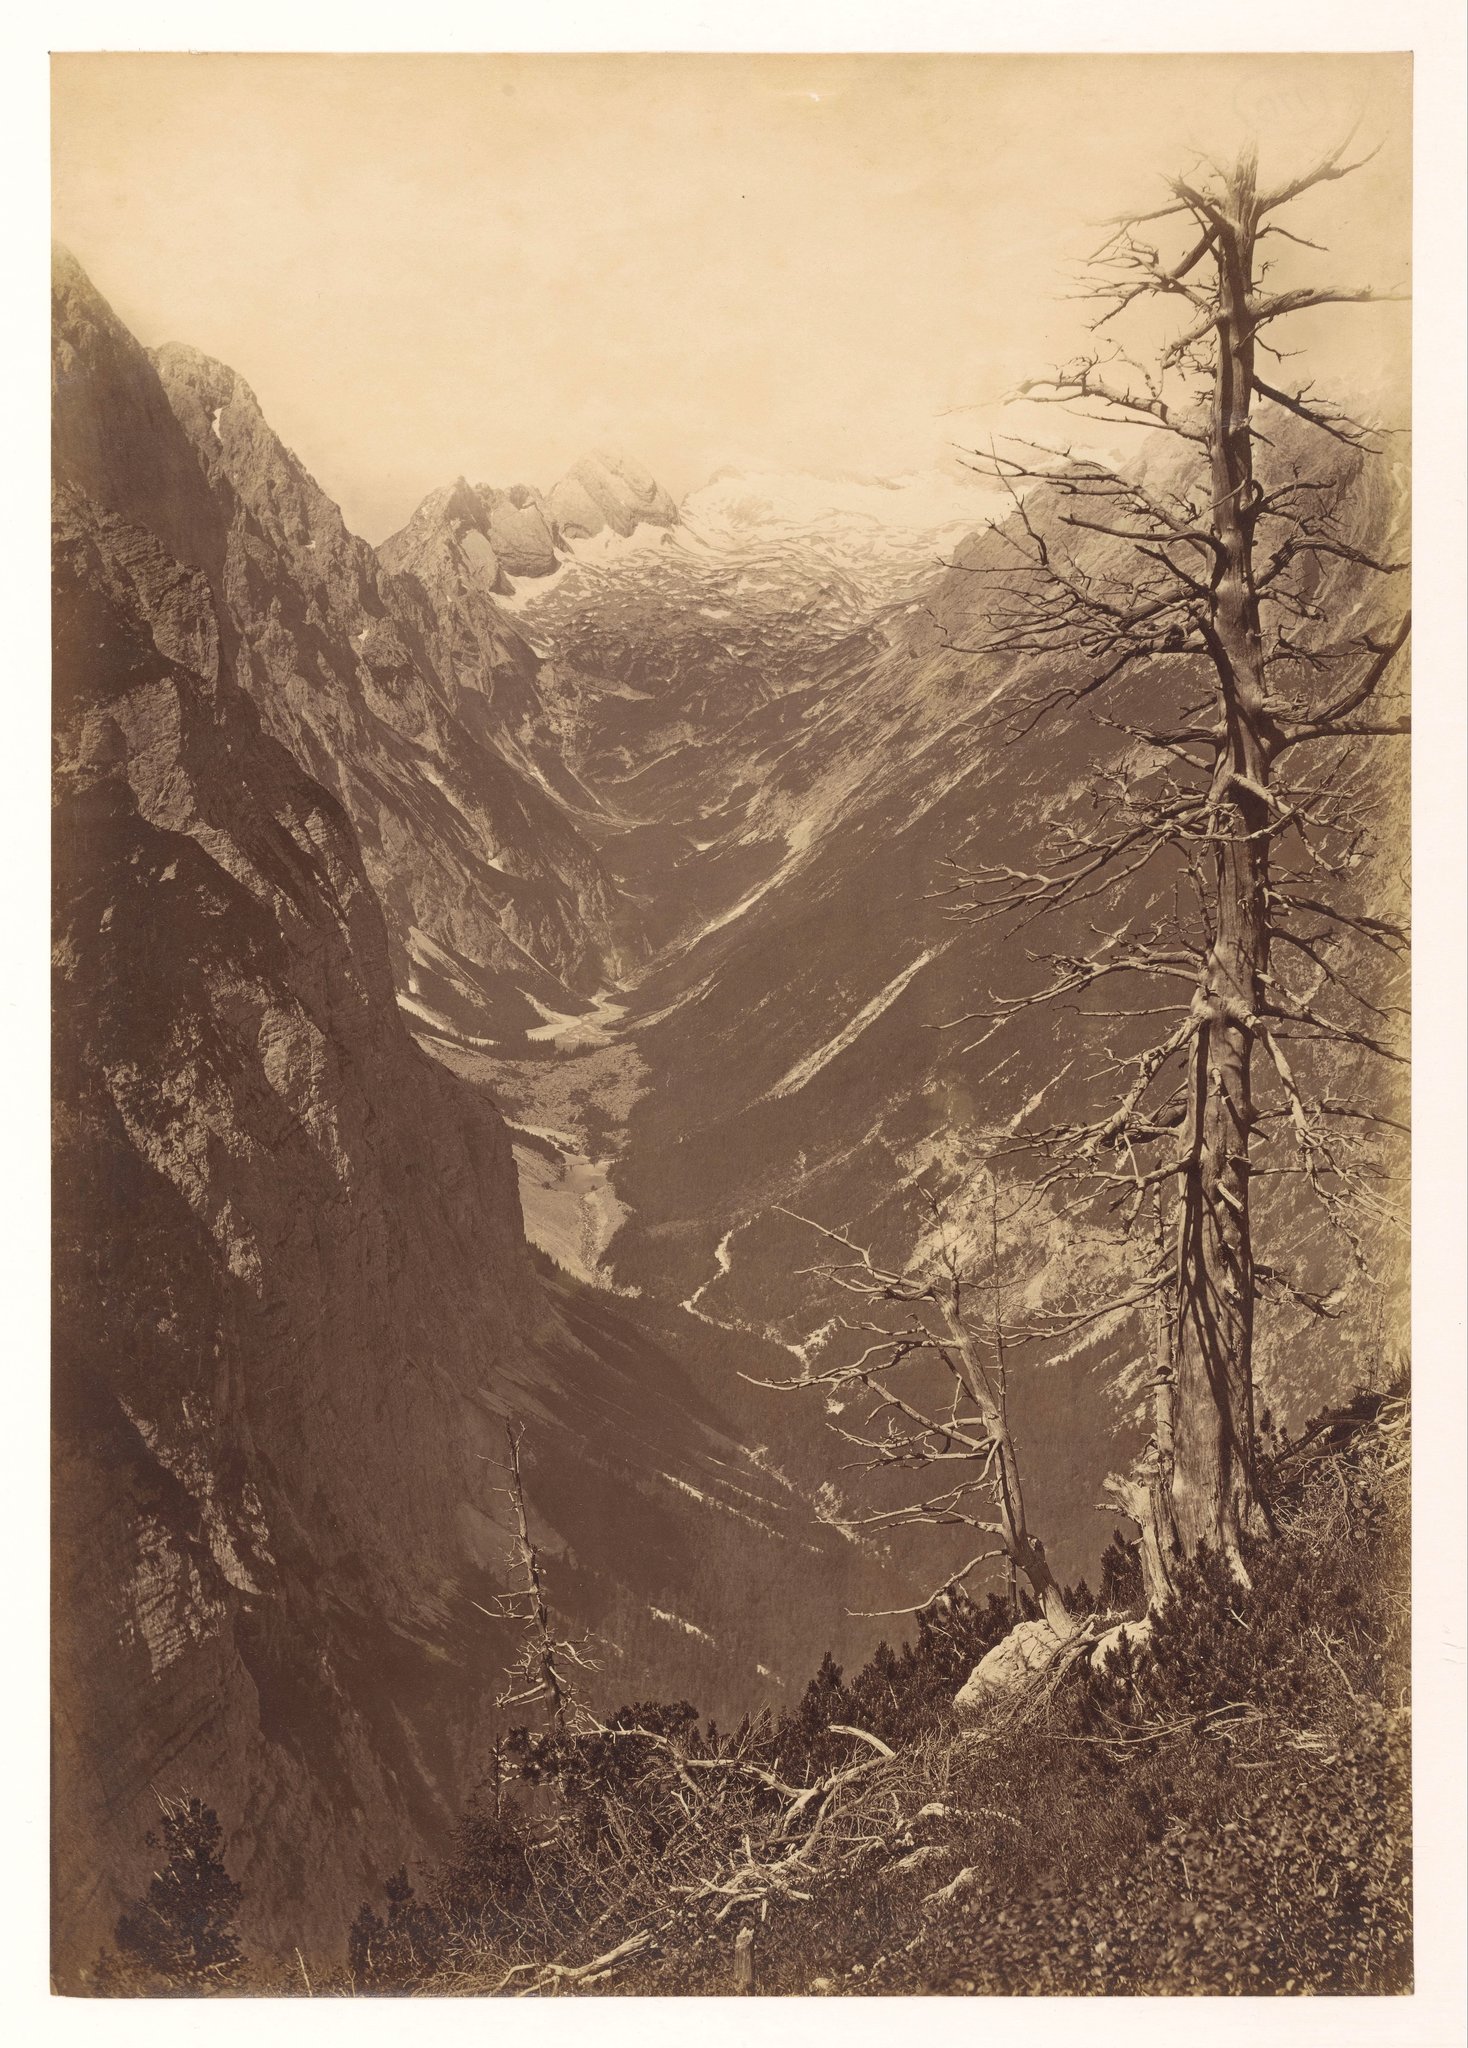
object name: photograph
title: Berglandschap met gletsjer en dode boom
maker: Anonymous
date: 1855-1880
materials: paper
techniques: albumen print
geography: germany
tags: glacier, mountains, germany